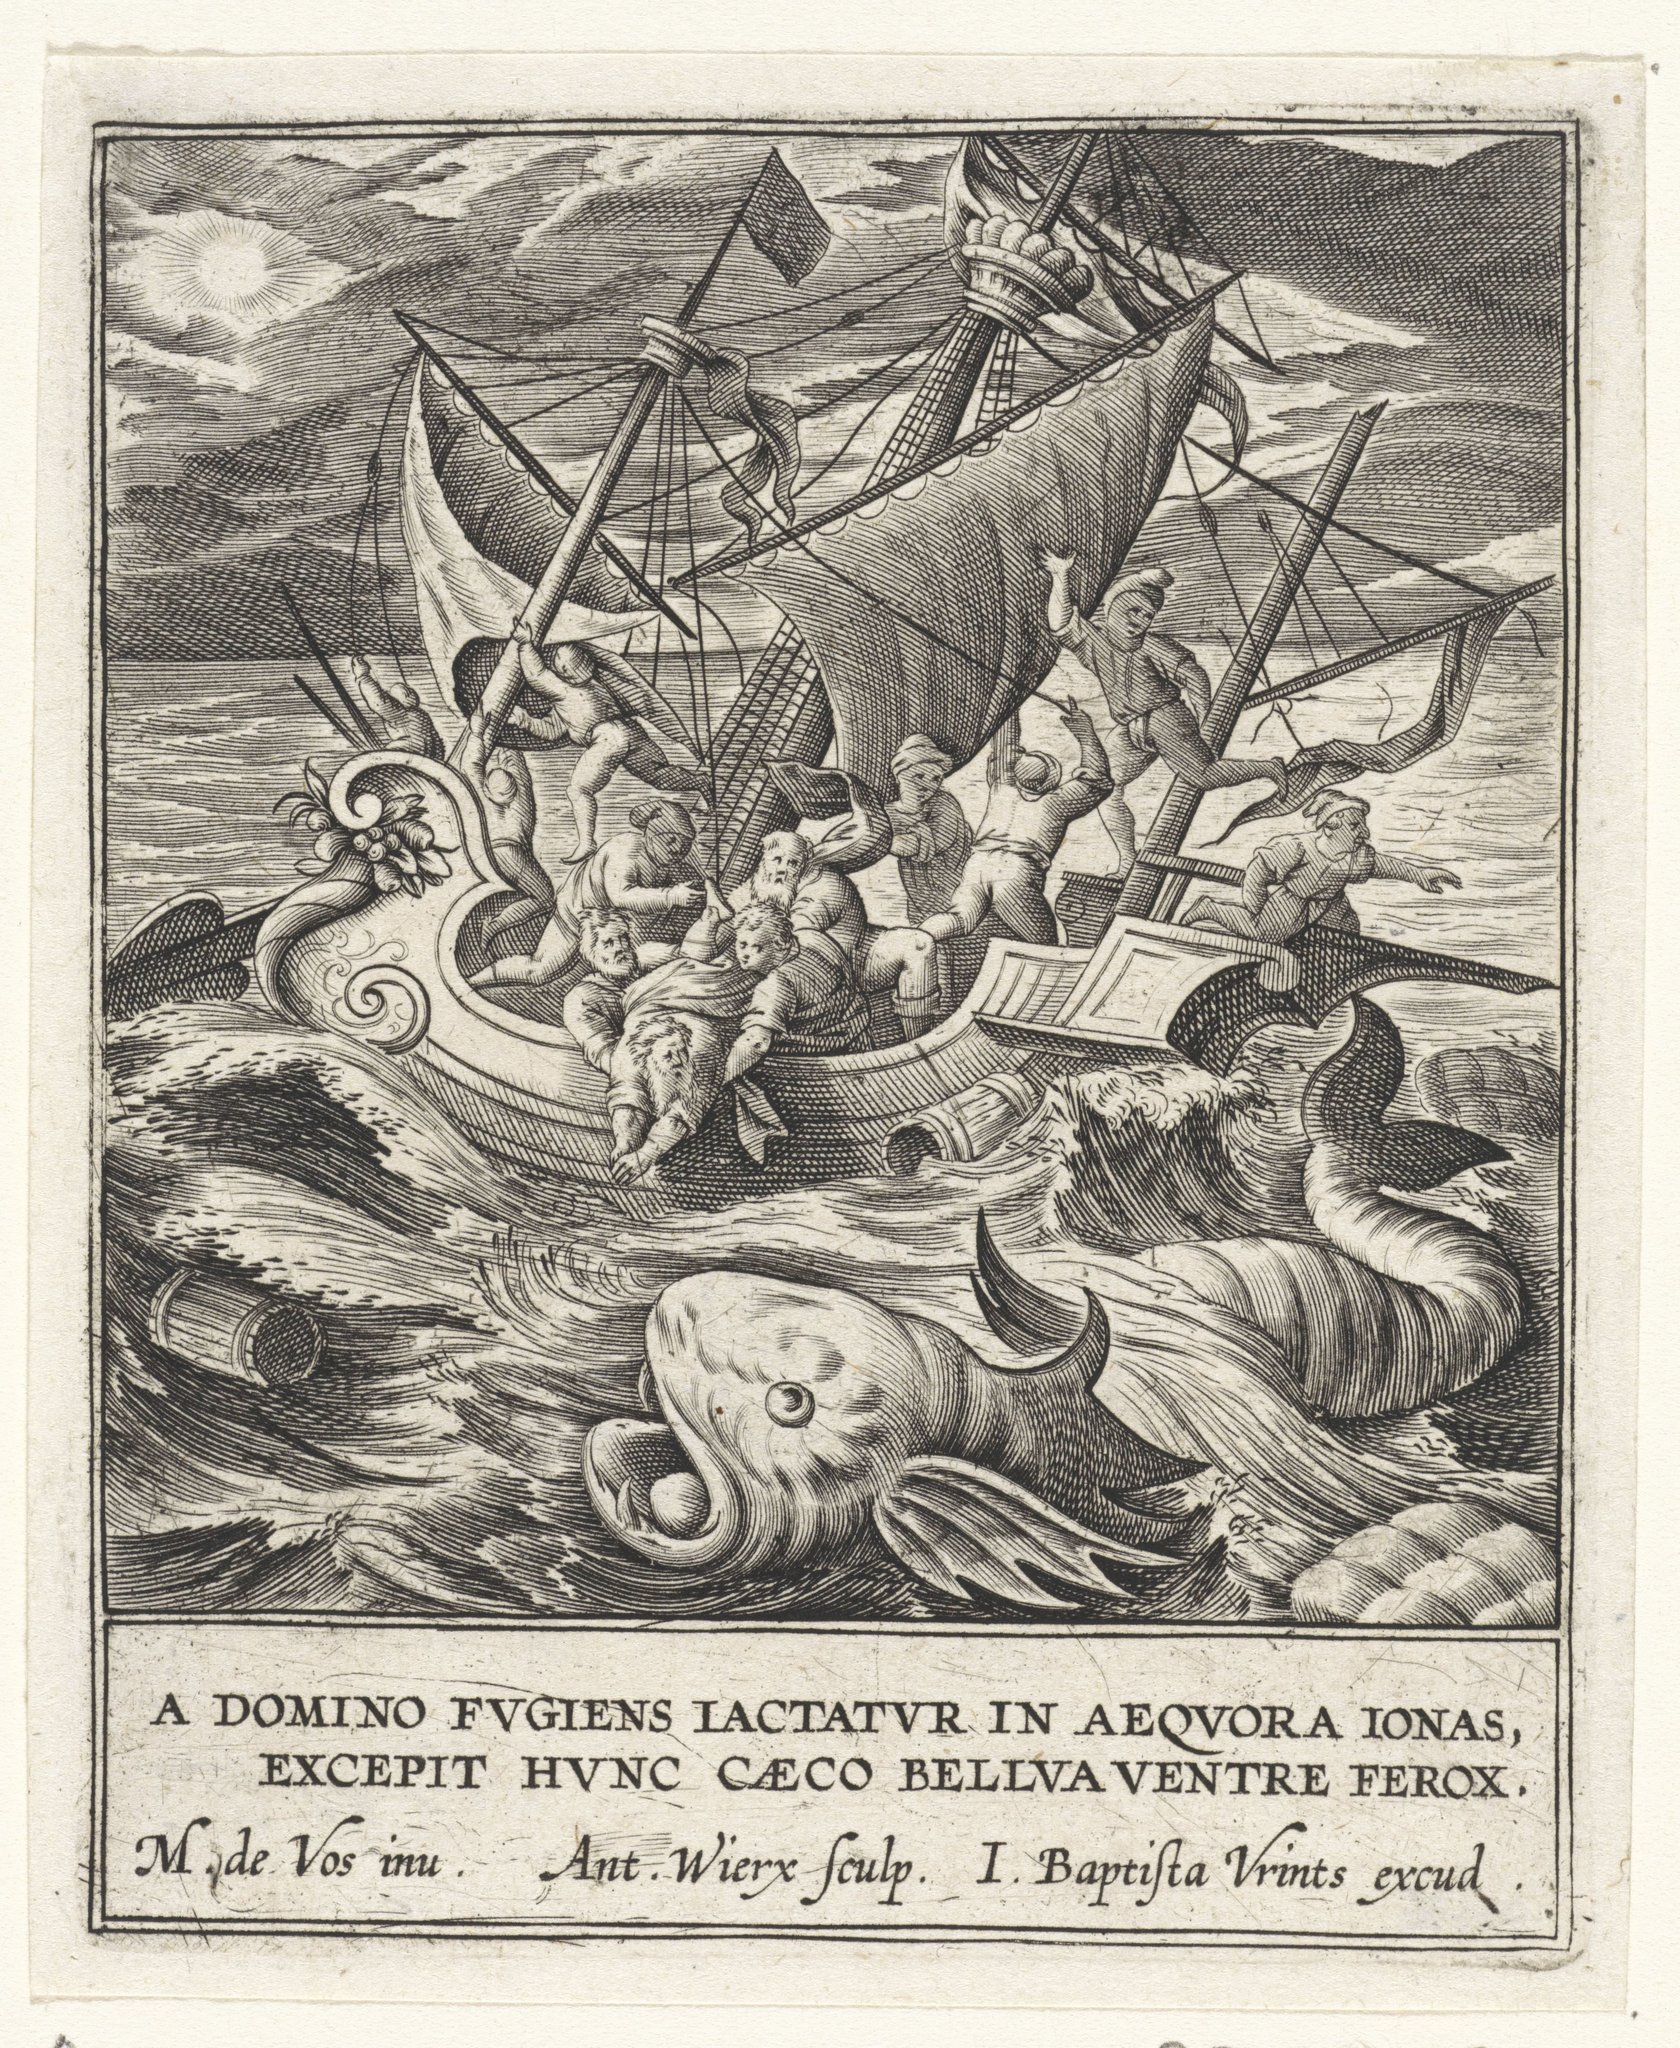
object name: print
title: Geschiedenis van Jona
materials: paper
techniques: engraving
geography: antwerp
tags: the sailors reluctantly throw the prophet jonah into the sea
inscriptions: collector's mark: Lugt 2542, collector's mark: Lugt 2228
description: Het schip waarop Jona vaart wordt door een zware storm geteisterd. Jona vraagt aan de zeelieden hem overboord te gooien om Gods kwaadheid te temperen. Een grote vis zwemt voor het schip. In de marge een tweeregelig onderschrift in het Latijn.